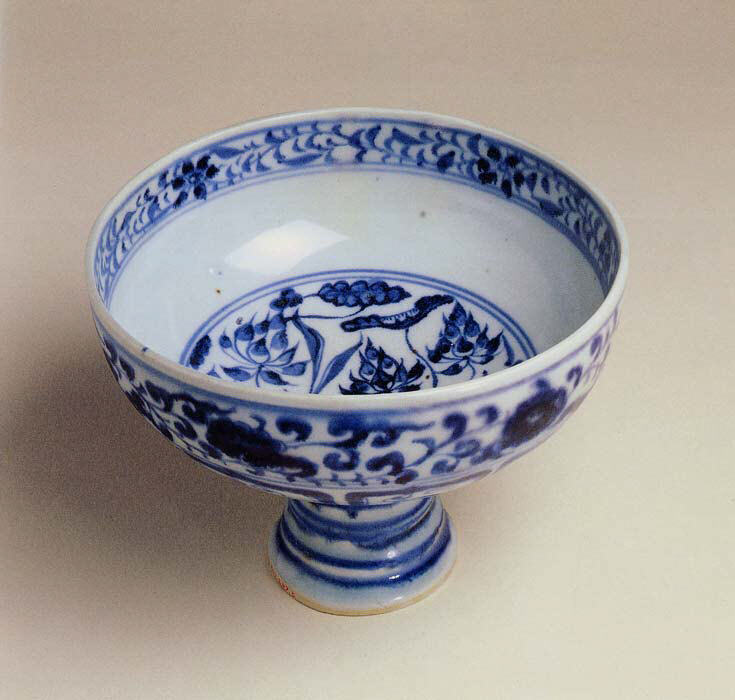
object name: stem bowl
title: Stem bowl with lotus pattern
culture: chinese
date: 1334-1366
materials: cobalt, porcelain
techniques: painting, underglaze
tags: flowers,leaves